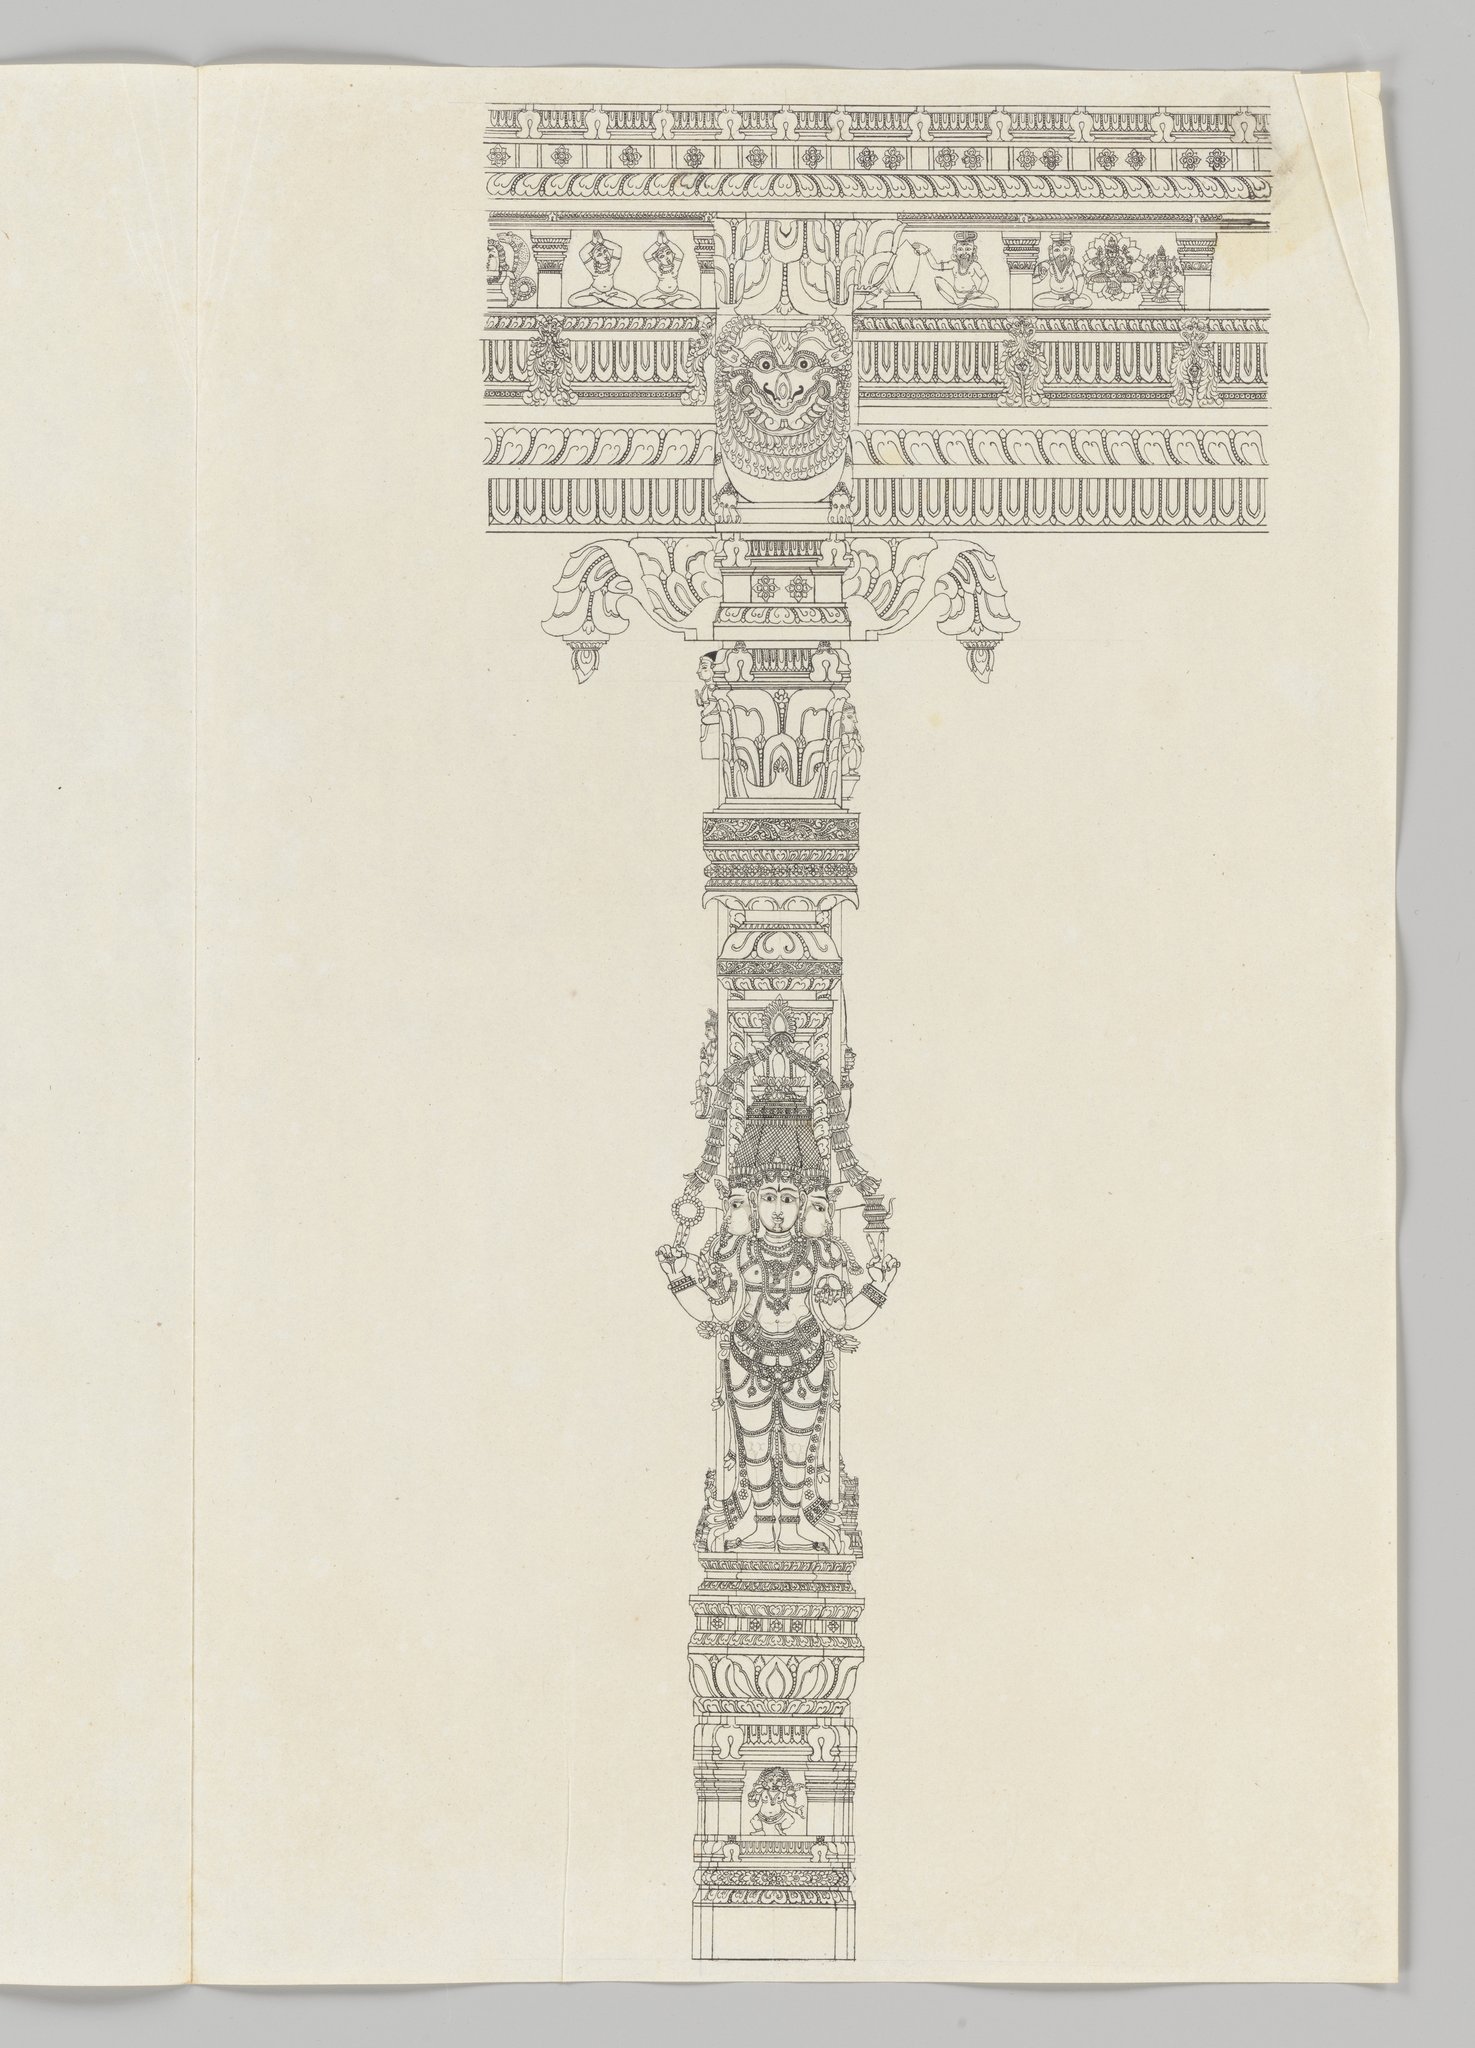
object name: drawing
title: Brahma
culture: indian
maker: unidentified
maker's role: artist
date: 1800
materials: ink, paper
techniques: wash